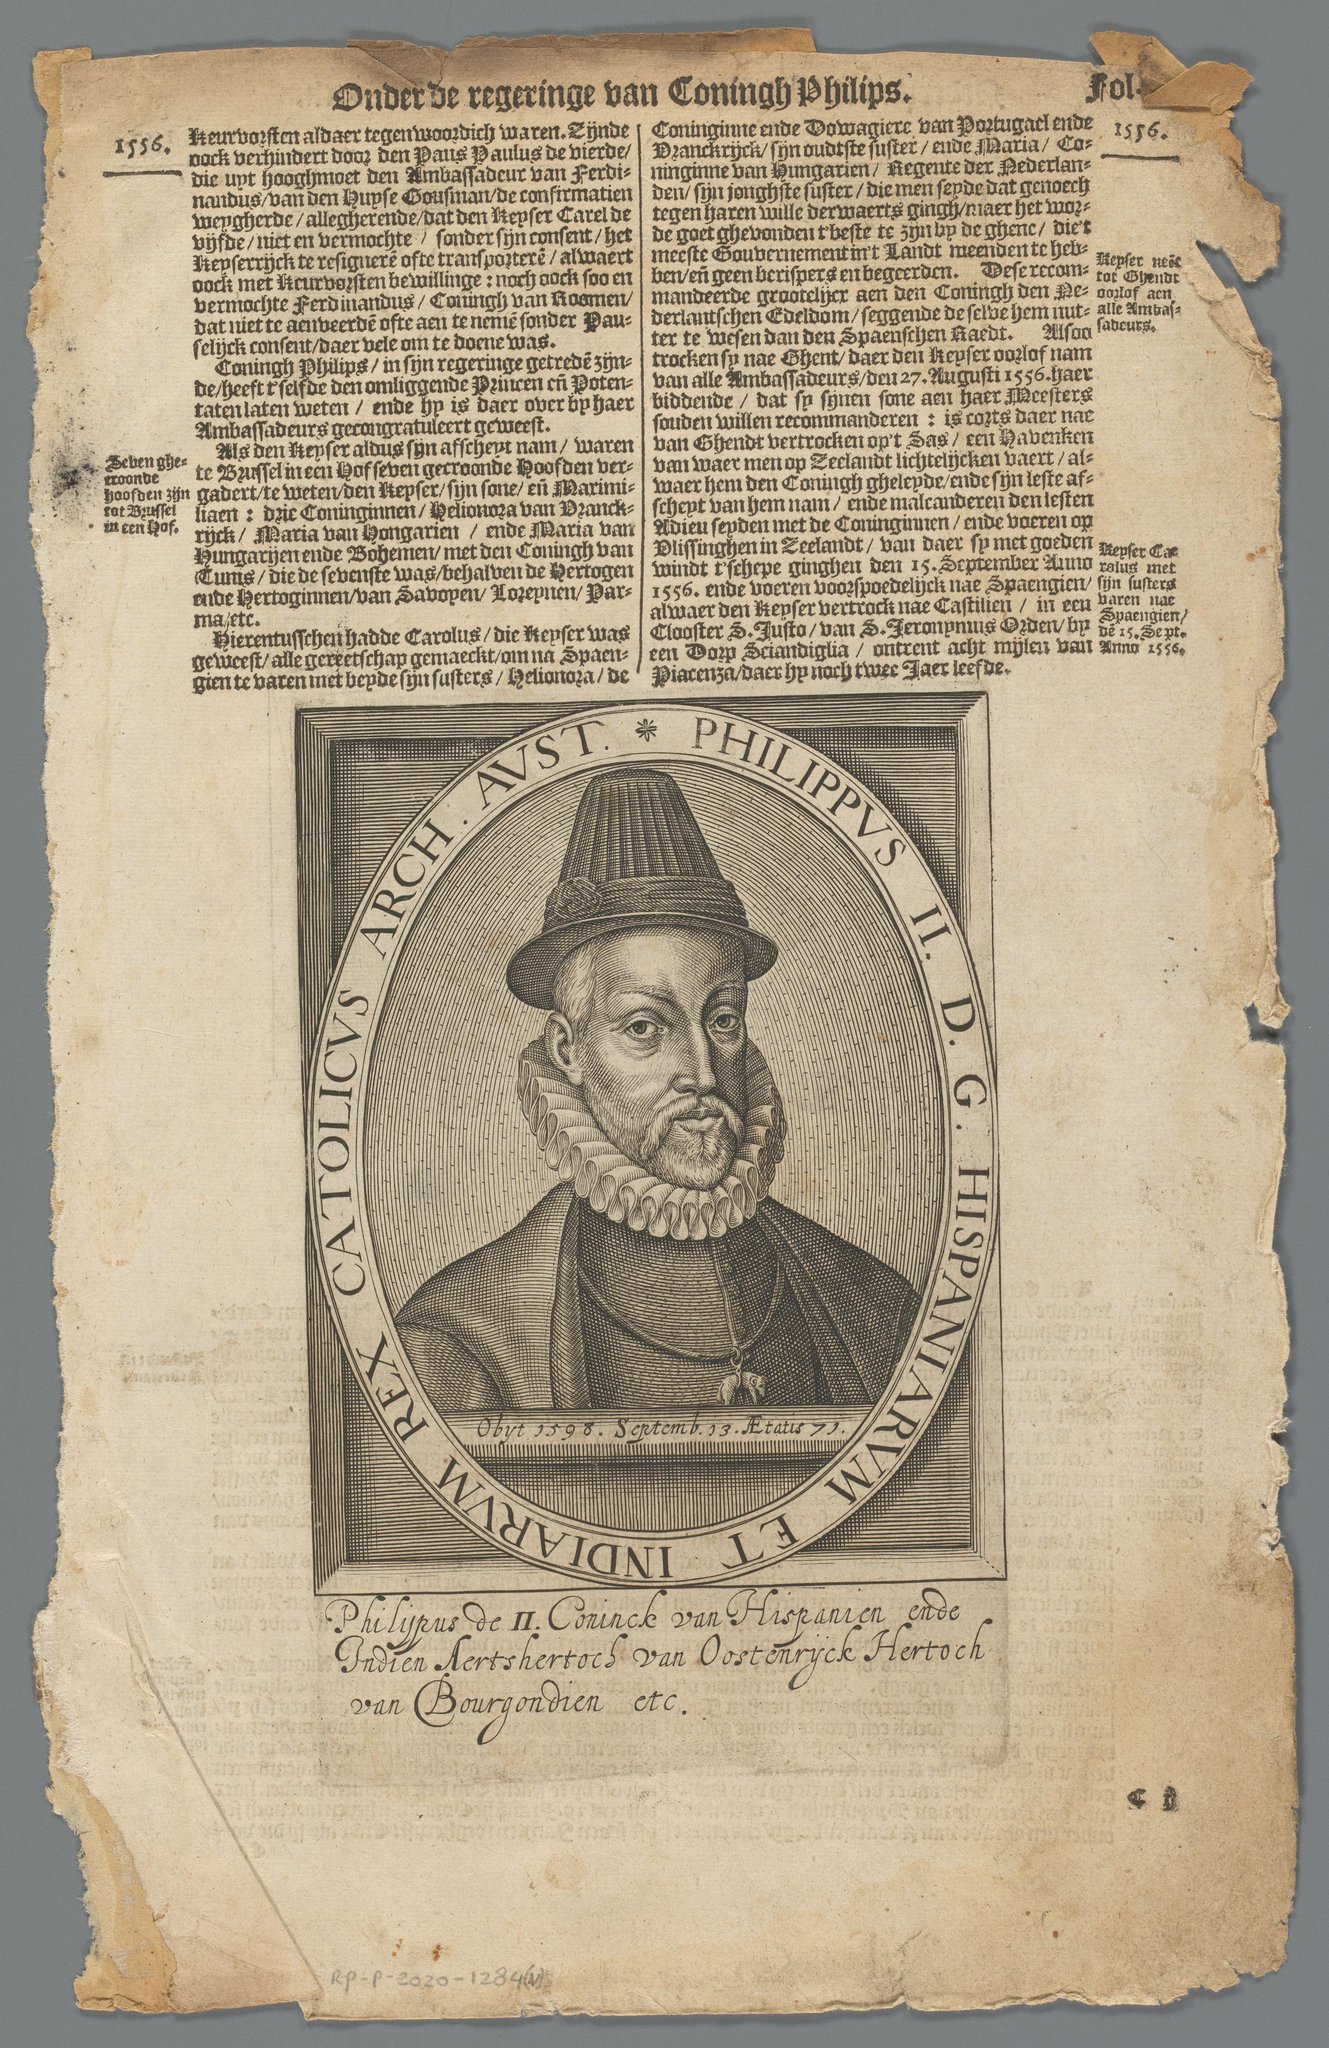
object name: text sheet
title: Philippus II. d.g. Hispaniarum et Indiarum rex catolicus arch. Aust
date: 1614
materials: paper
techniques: engraving, letterpress printing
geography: the hague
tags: philip ii of spain, historical persons, king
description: Prent uit: Meteren, Emanuel van. Historie der Nederlandscher ende haerder na-buren oorlogen ende geschiedenissen (...). Den Haag: Hillebrant Iacobsz. van Wouw, 1614.